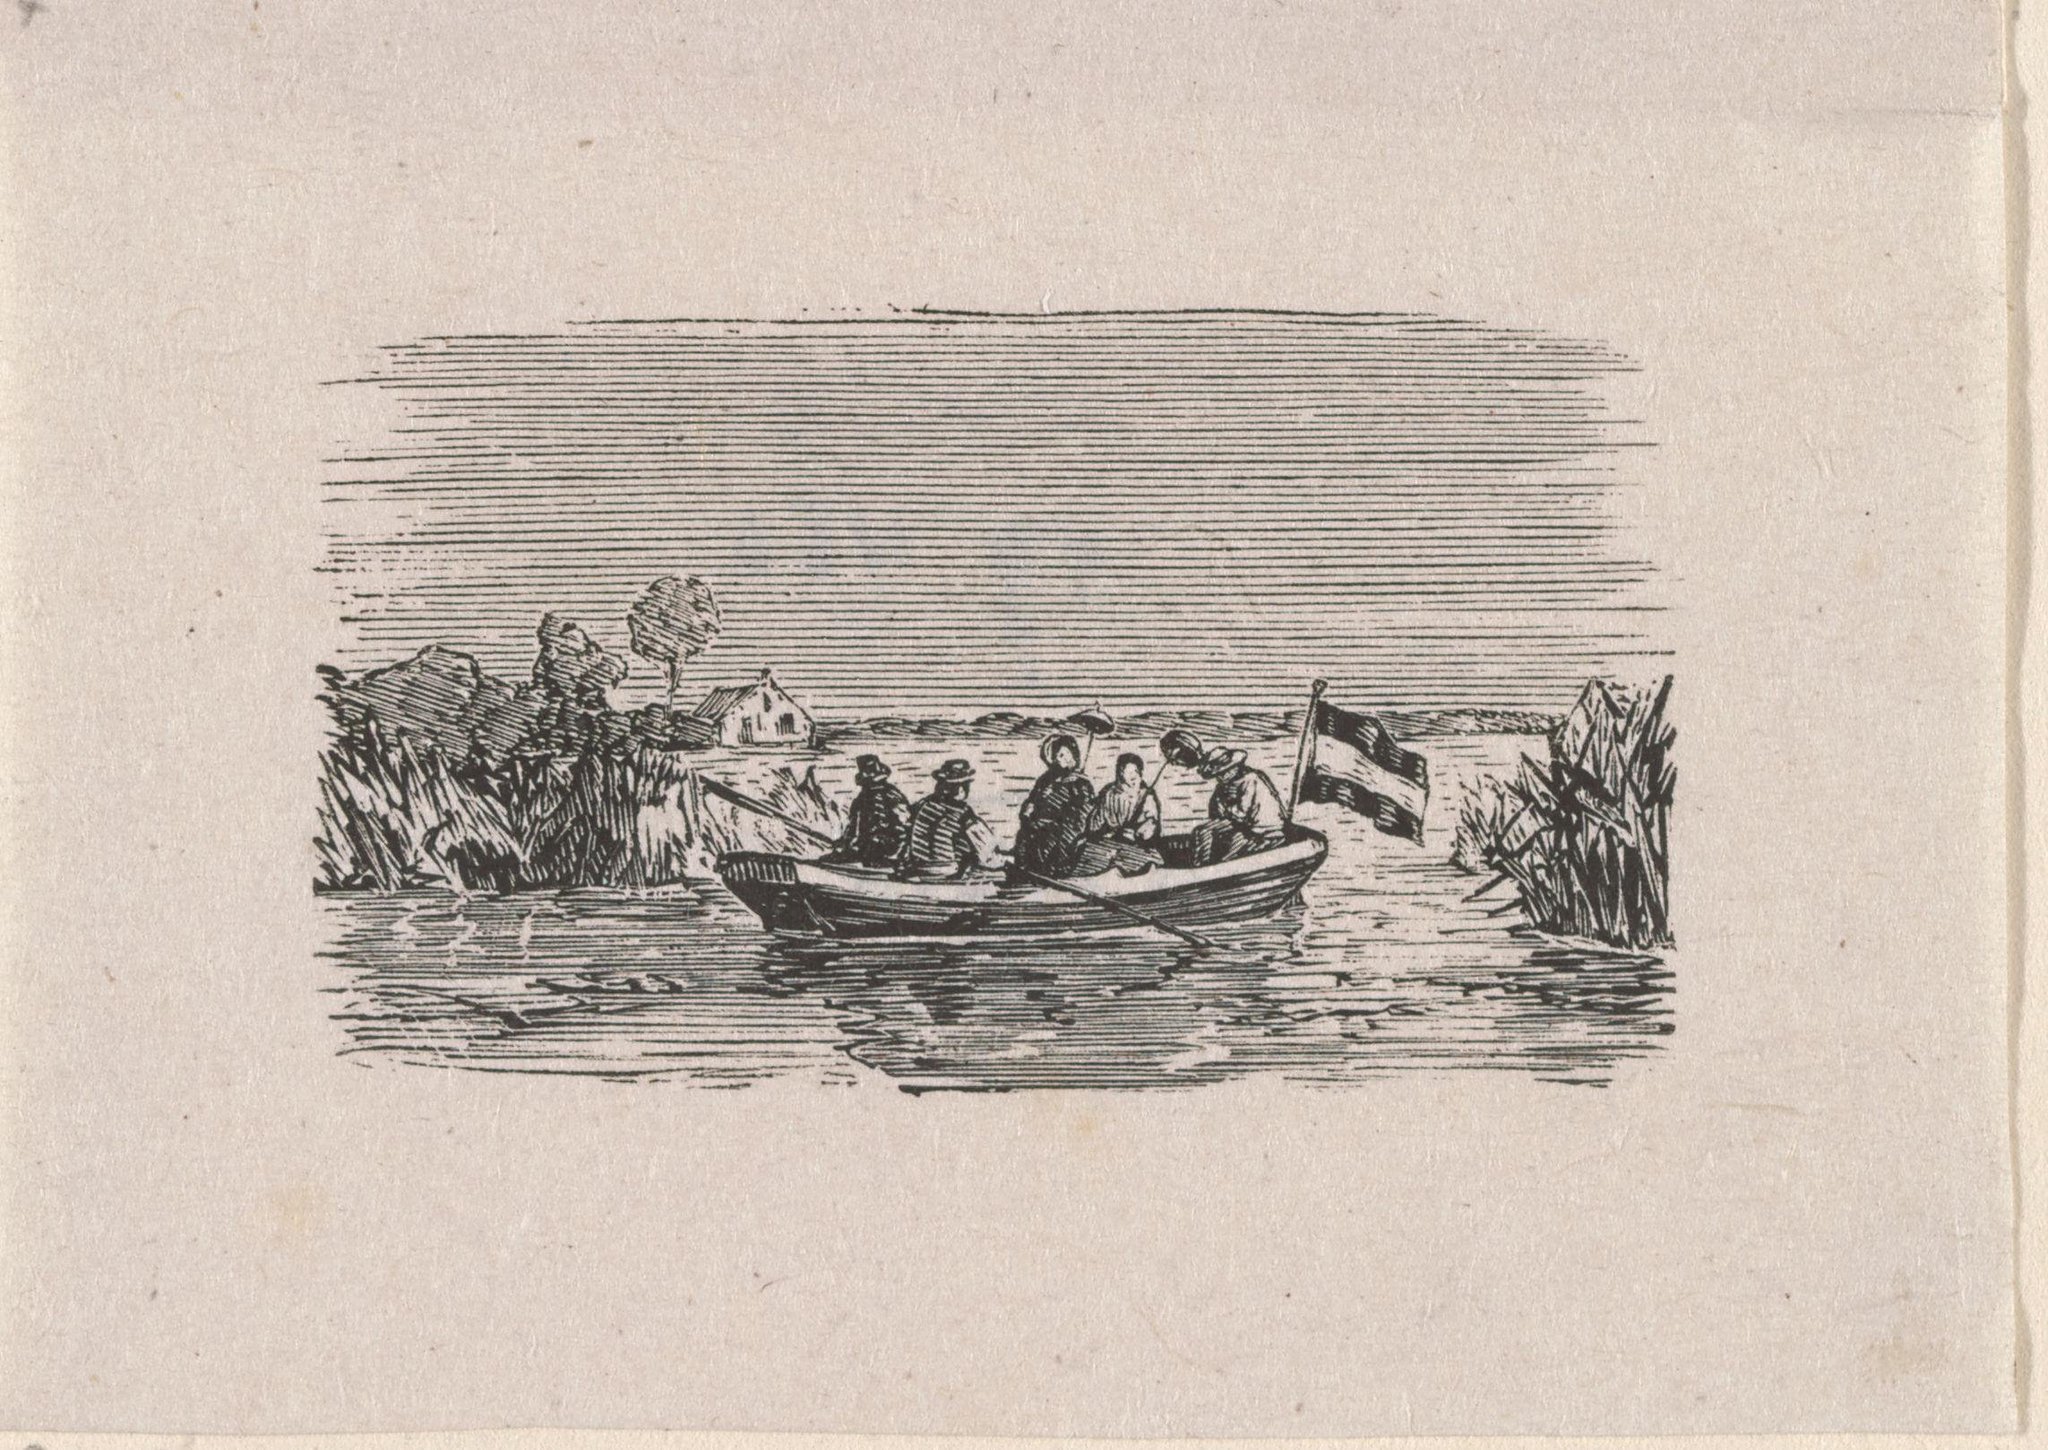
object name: print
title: Maanden van het jaar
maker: isaac weissenbruch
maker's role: print maker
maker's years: 1826-1912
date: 1836-1912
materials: paper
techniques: engraving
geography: netherlands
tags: adult man (+ sitting), the twelve months represented by scenes showing human activities, usually in a landscape; so-called 'labours of the months', fishing (sports), adult woman (+ sitting)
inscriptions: collector's mark: Lugt 2228